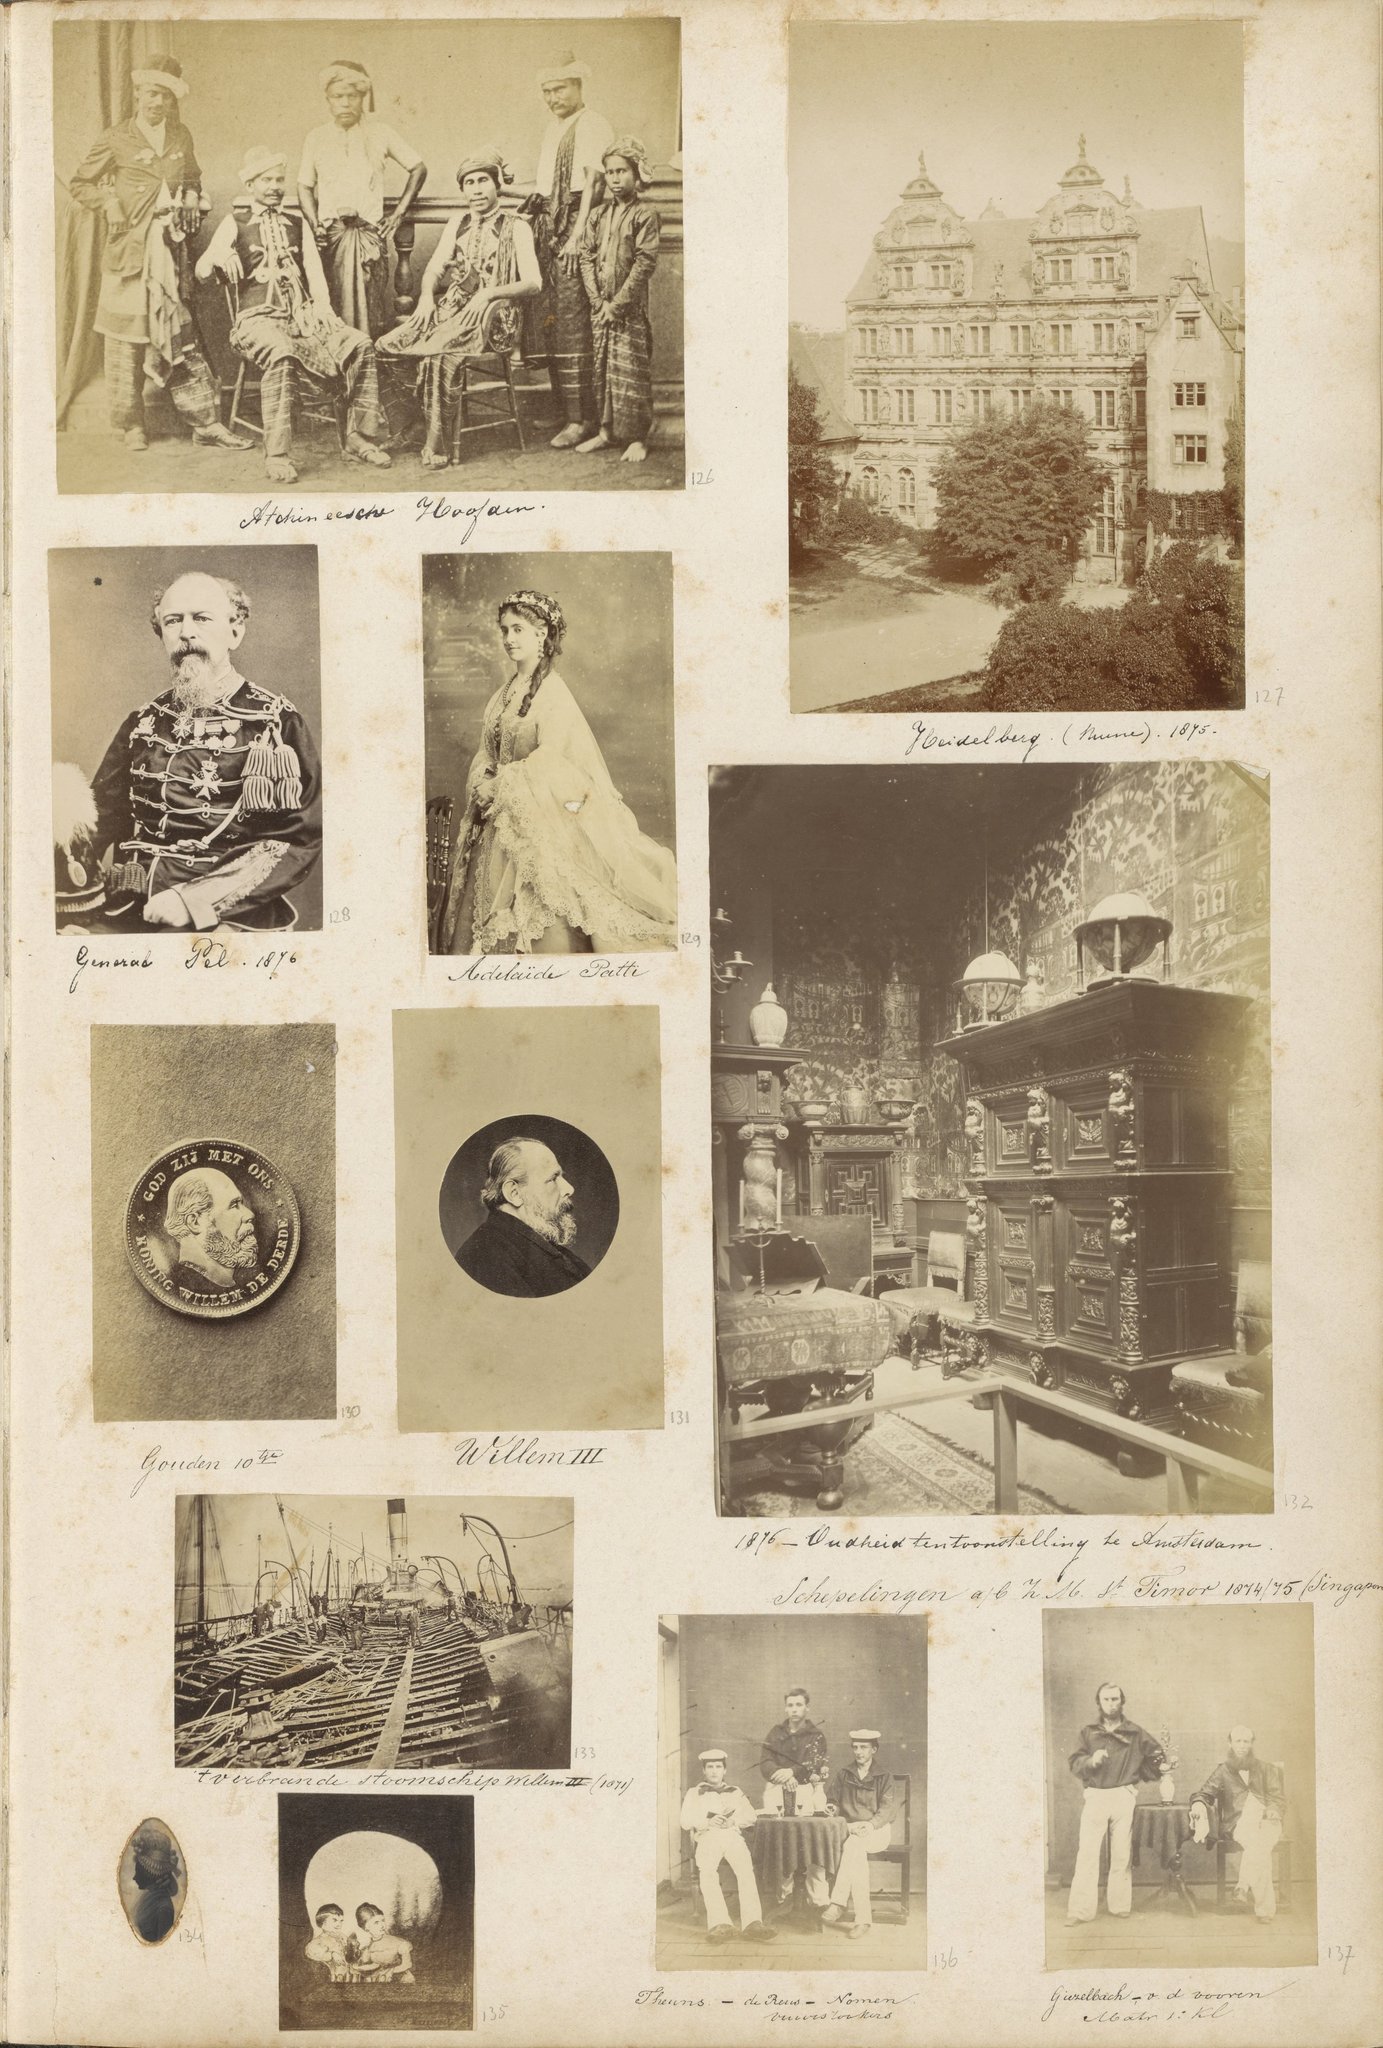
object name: album leaf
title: Portret van generaal J.L.J.H. Pel, bevelhebber van Atjeh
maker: Anonymous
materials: paper, photographic support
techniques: albumen print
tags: commander-in-chief, general, marshal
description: Onderdeel van Fotoalbum van Robert Daniel Crommelin (1841-1907).